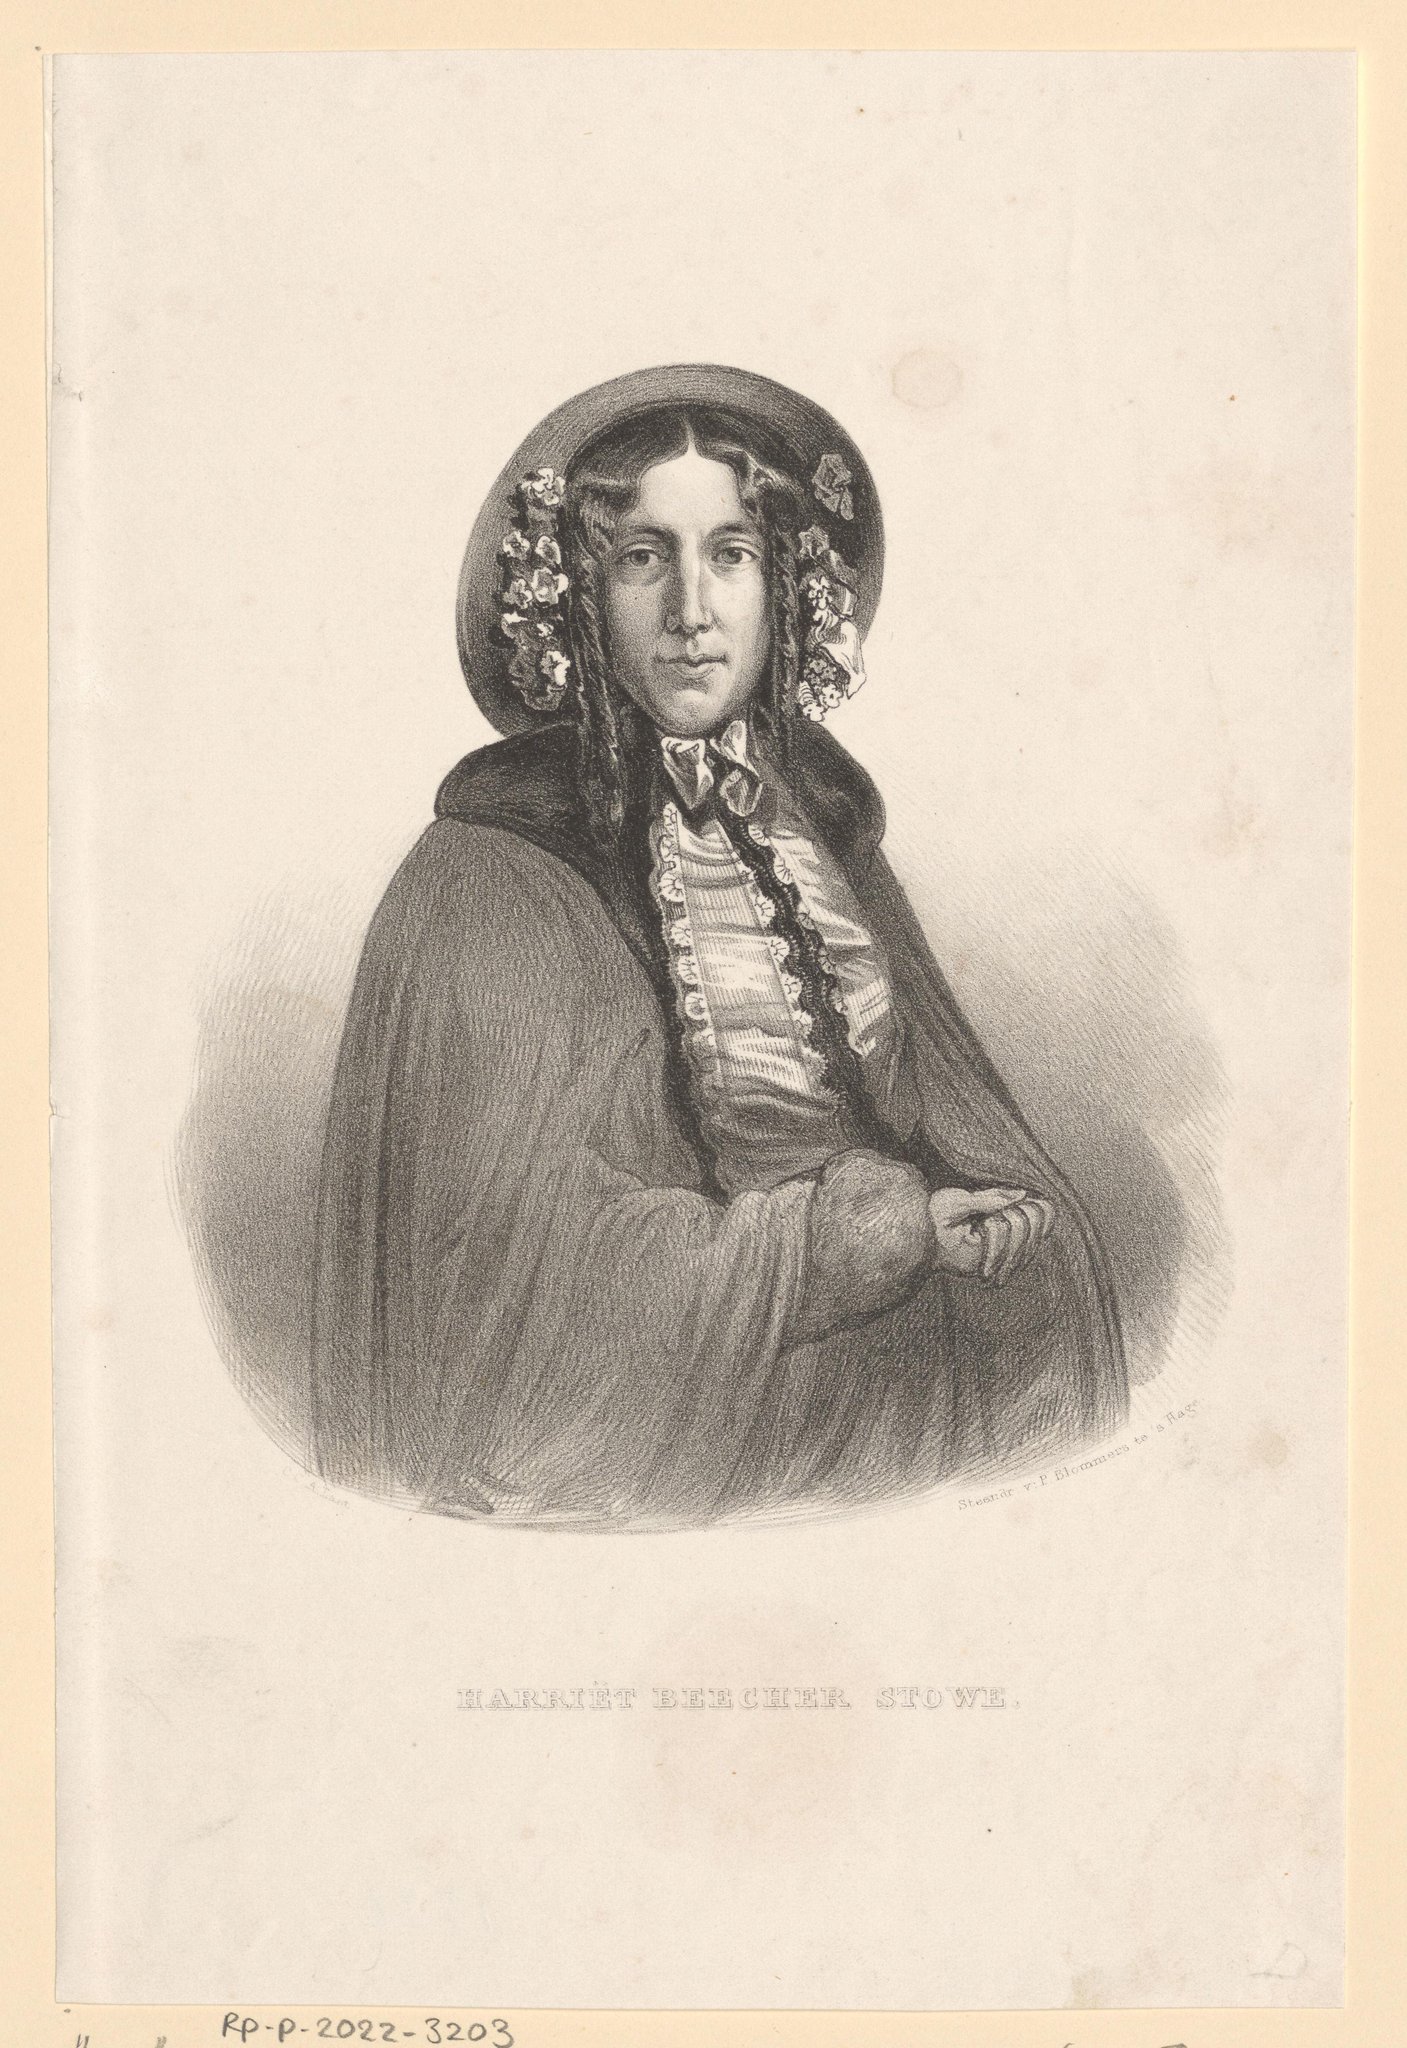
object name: print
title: Portret van Harriet Beecher Stowe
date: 1842-1876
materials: paper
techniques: lithograph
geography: the hague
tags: historical persons - bb - woman, portrait of a writer